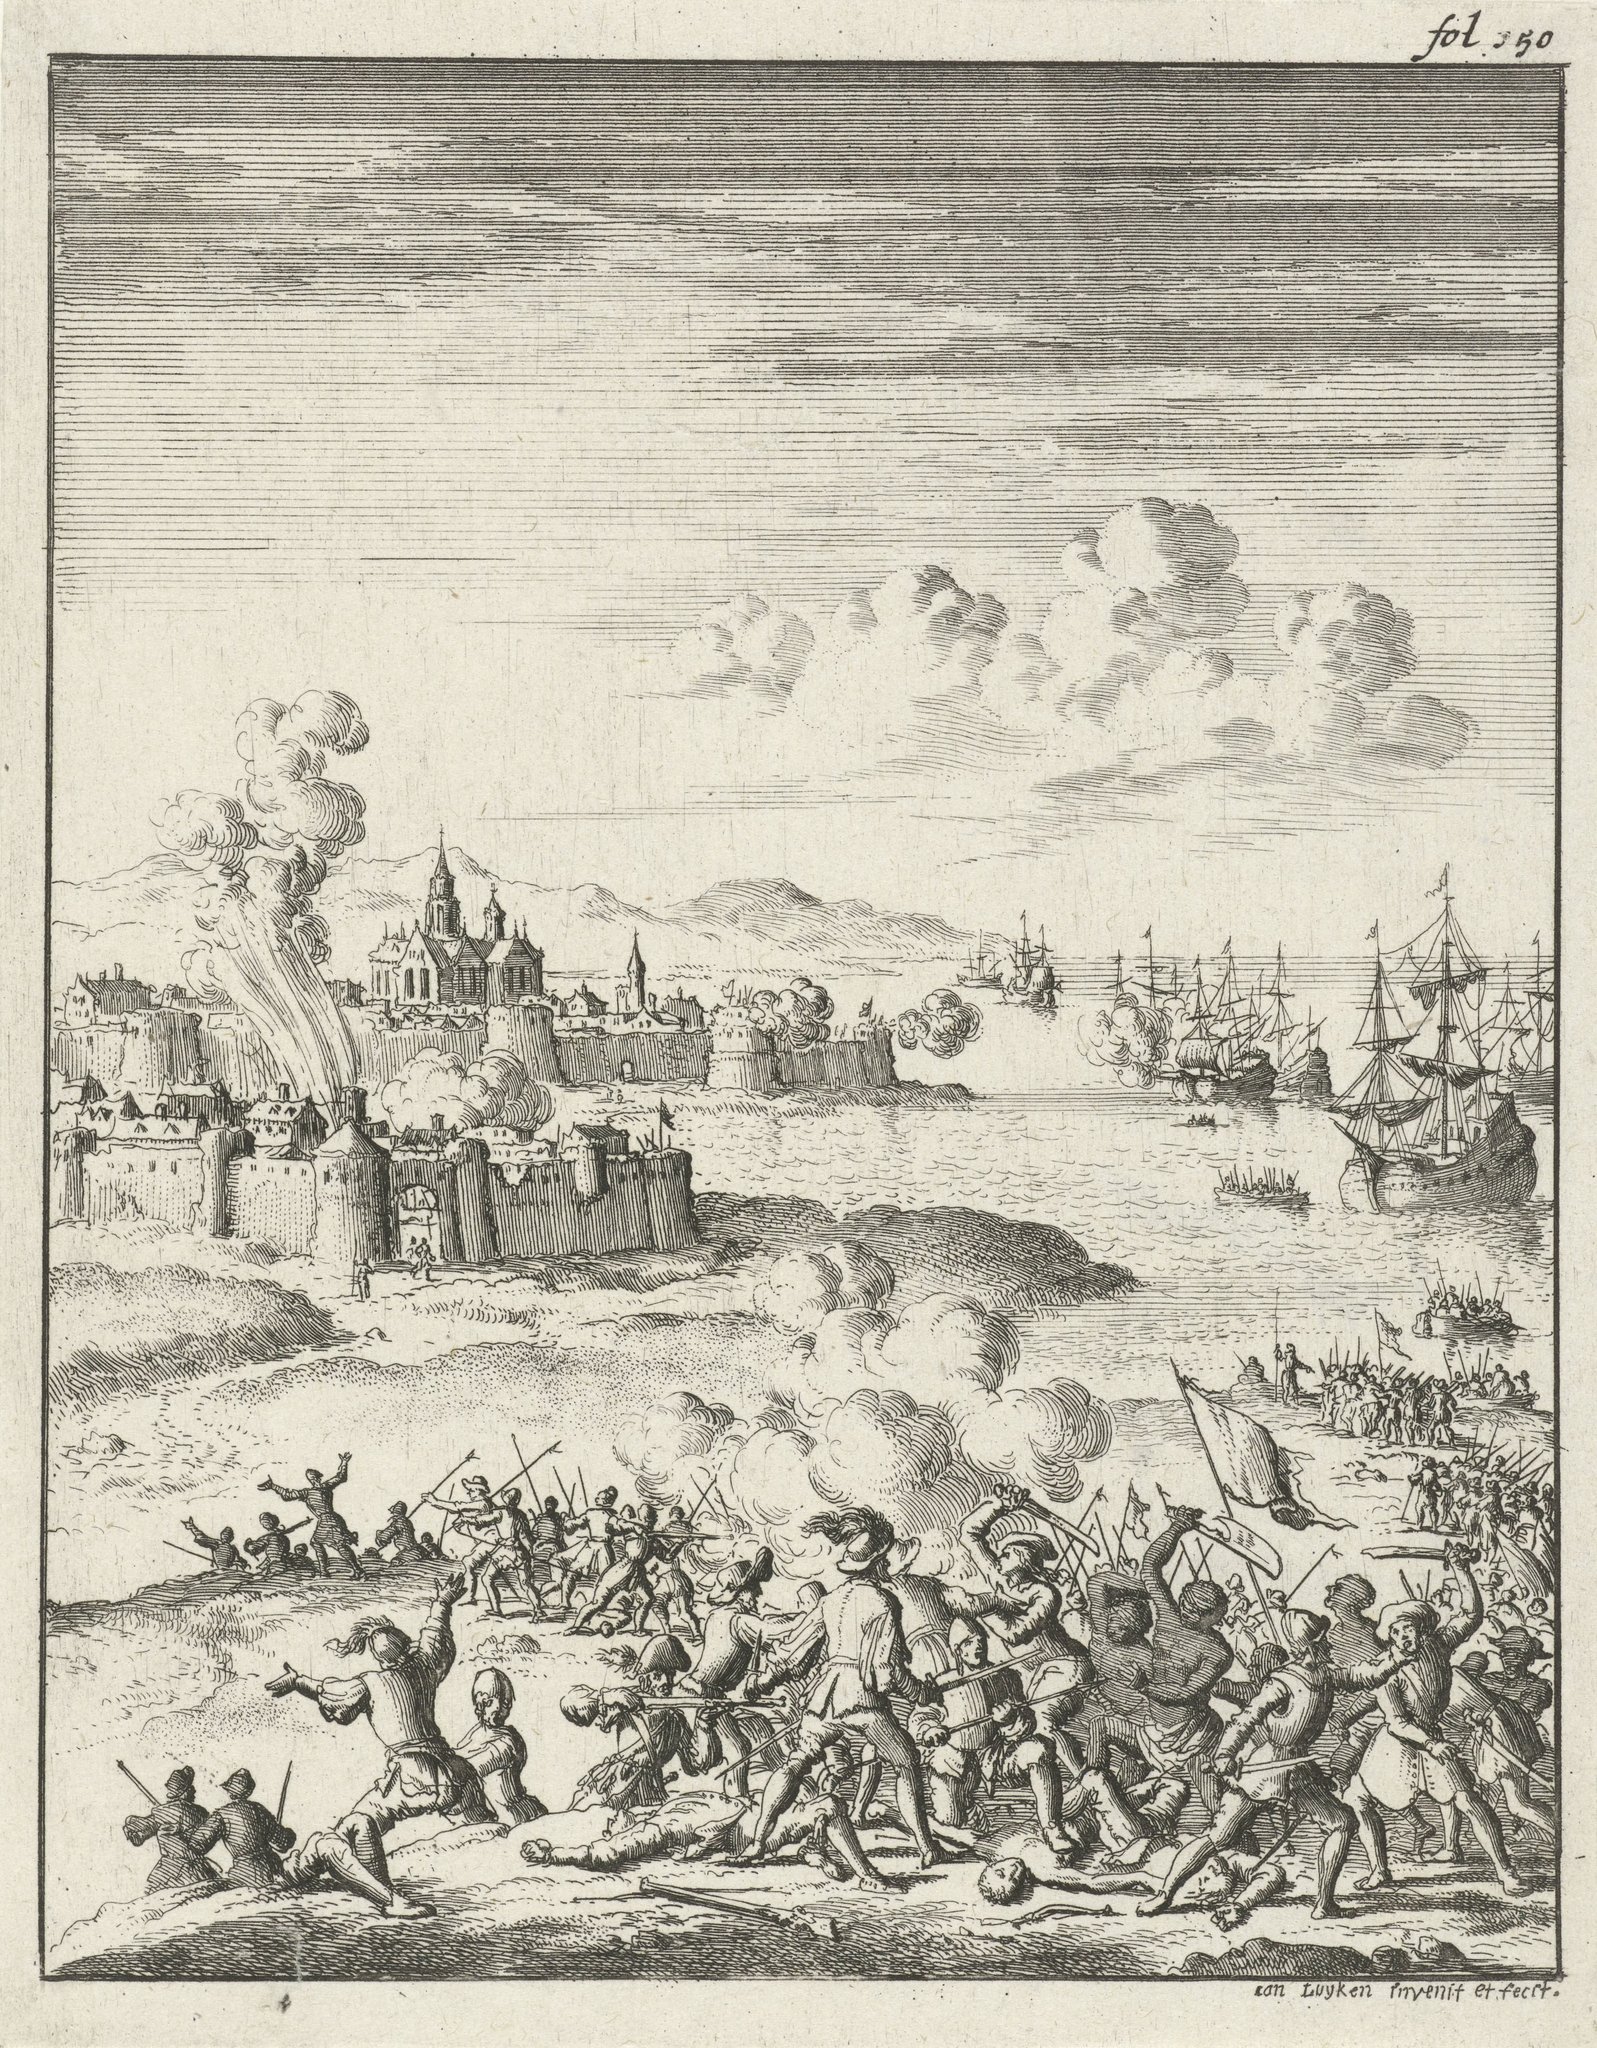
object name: book illustration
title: Melaka onder leiding van Cornelis Matelief de Jonge belegerd, 1606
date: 1683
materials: paper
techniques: etching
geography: amsterdam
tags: rotterdam, exploration, expedition, voyage of discovery, siege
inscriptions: collector's mark: Lugt 2228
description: Illustratie uit: Bos, Lambert van den. Leeven en daaden der doorluchtigste zee-helden. Amsterdam: Jan Bouman (I) en Jan Claesz ten Hoorn, 1683.